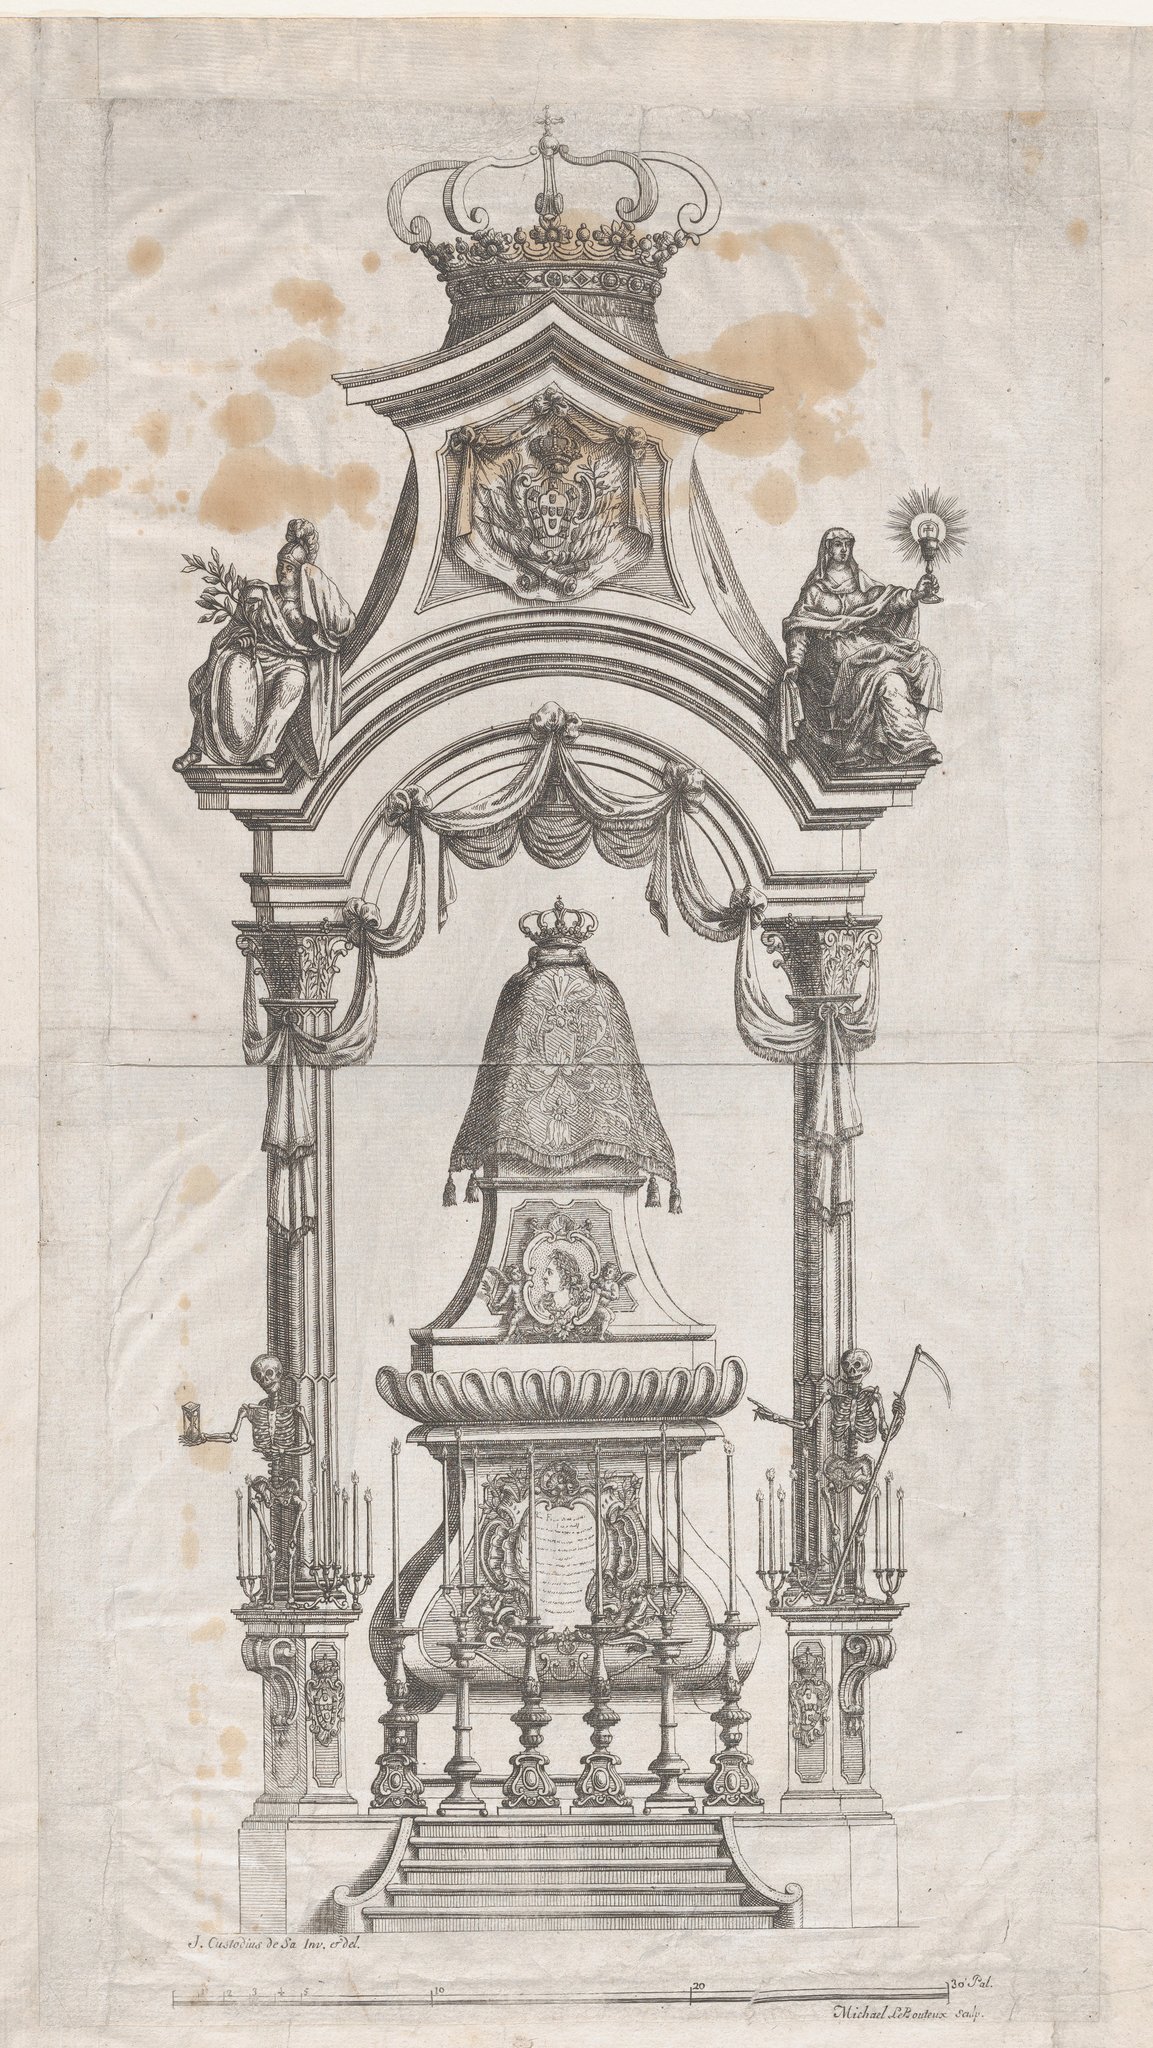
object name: print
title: Royal Portugese Funeral Monument (possibly part of a funeral book)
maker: michel bouteux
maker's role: artist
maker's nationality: french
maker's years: 1600-1700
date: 1667-1733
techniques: etching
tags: architecture,skeletons,funerals,coat of arms